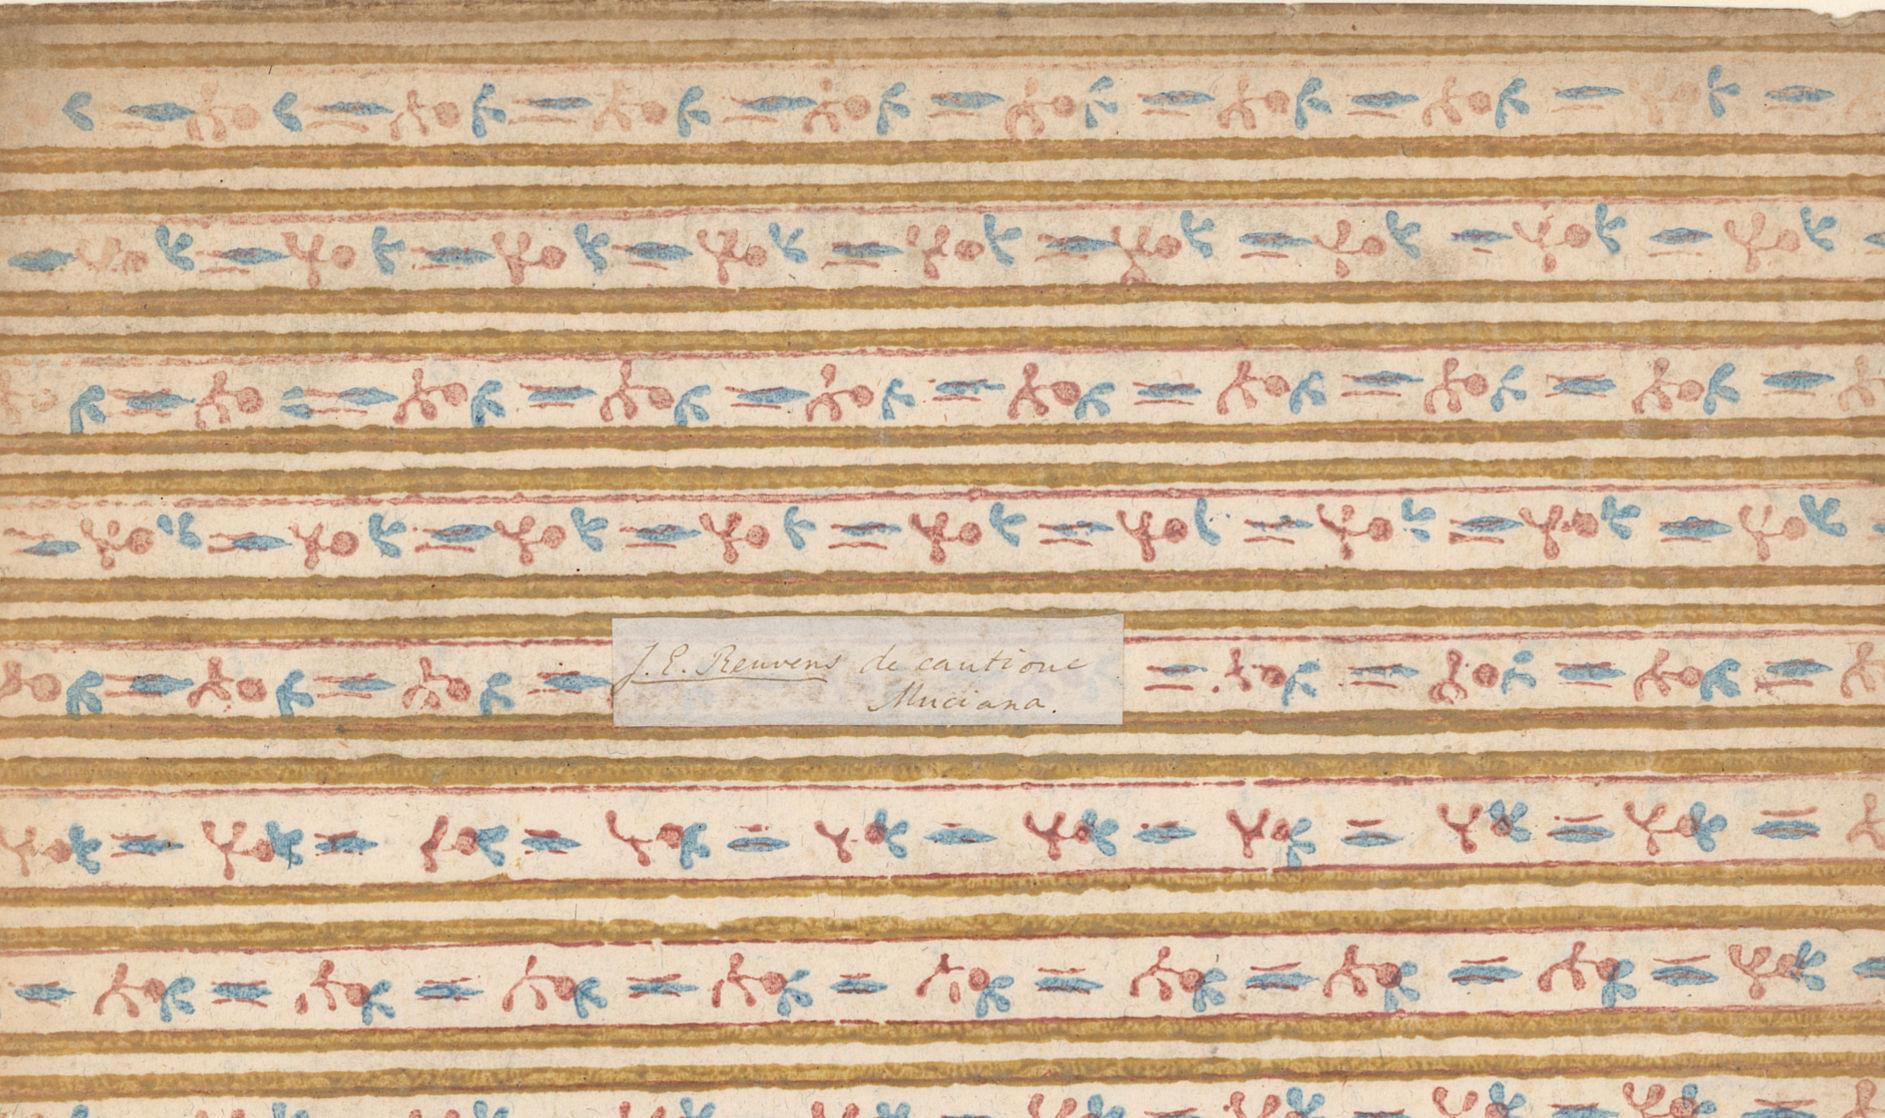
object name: printed paper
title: Blad met banenpatroon van twee lijnen met als baanvulling takje met vrucht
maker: Anonymous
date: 1750-1900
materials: paper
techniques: printing block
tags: ornament derived from plant forms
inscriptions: collector's mark: Lugt 2760, collector's mark: Lugt 2228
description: Blad met banenpatroon van twee lijnen met als baanvulling takje met vrucht. Met etiket met opschrift: 'J.E. Reuvens ... Muciana.' Helft van een omslag.